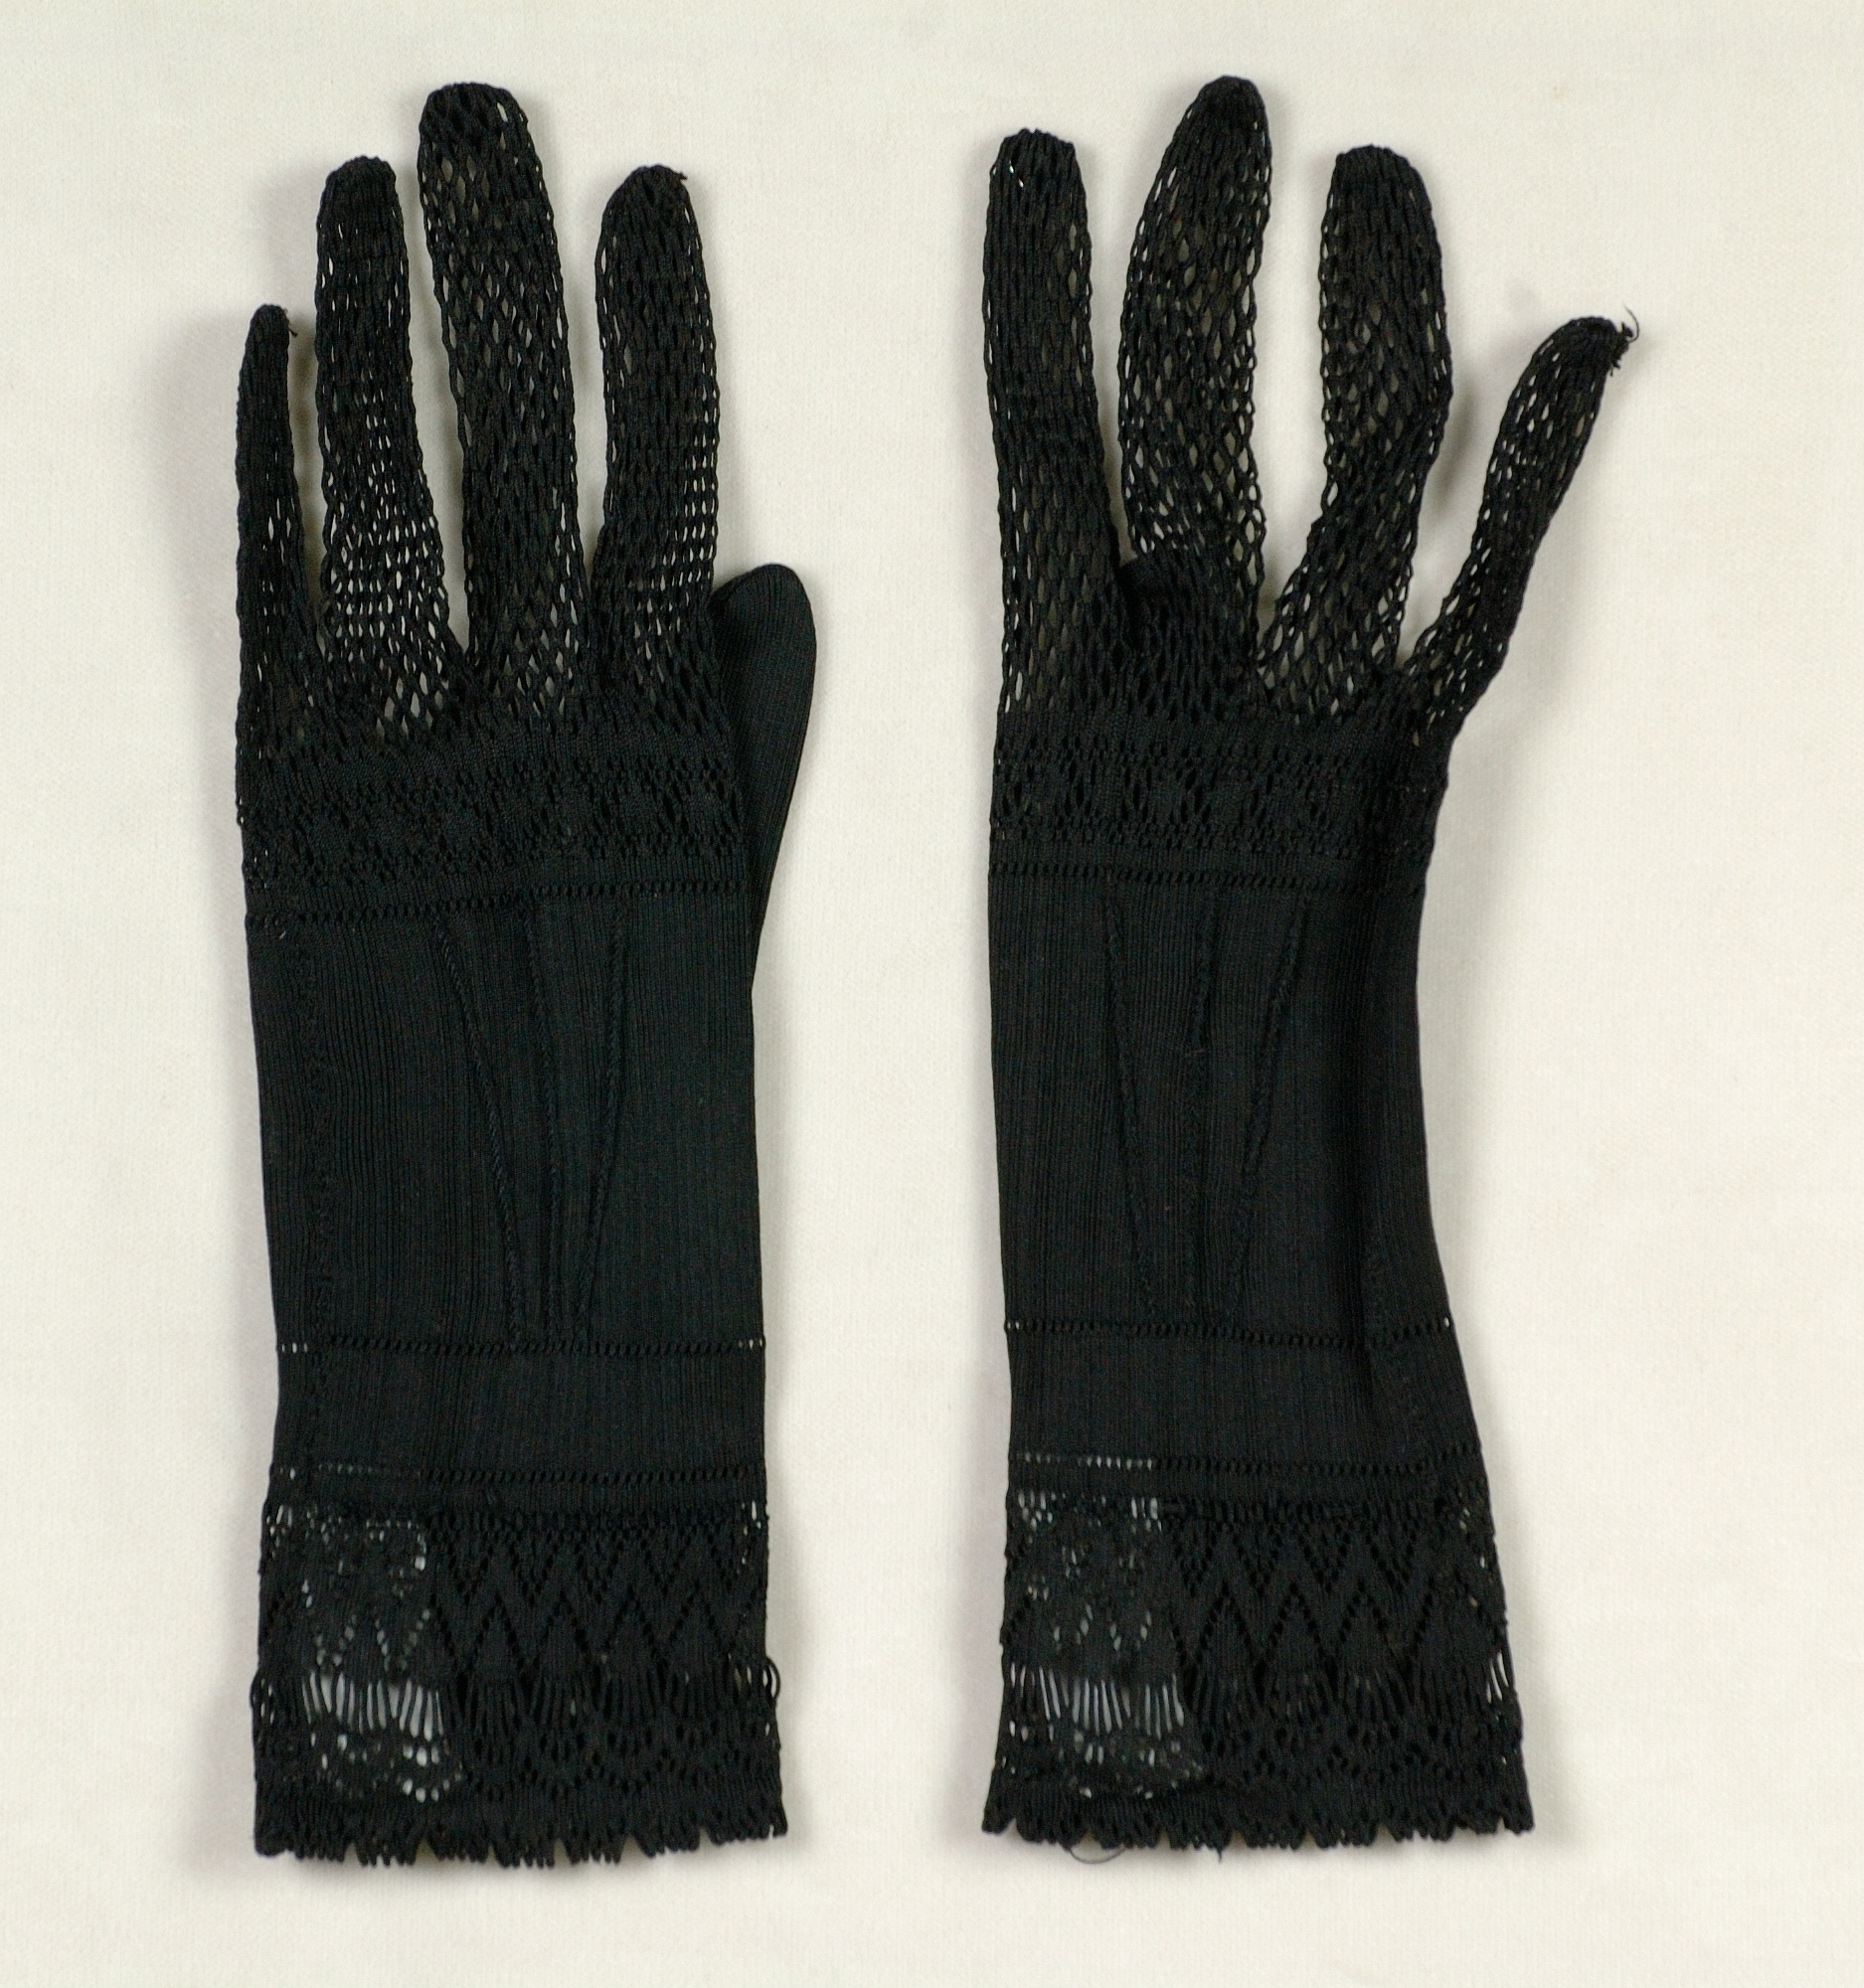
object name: glove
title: Gloves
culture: american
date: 1870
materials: silk